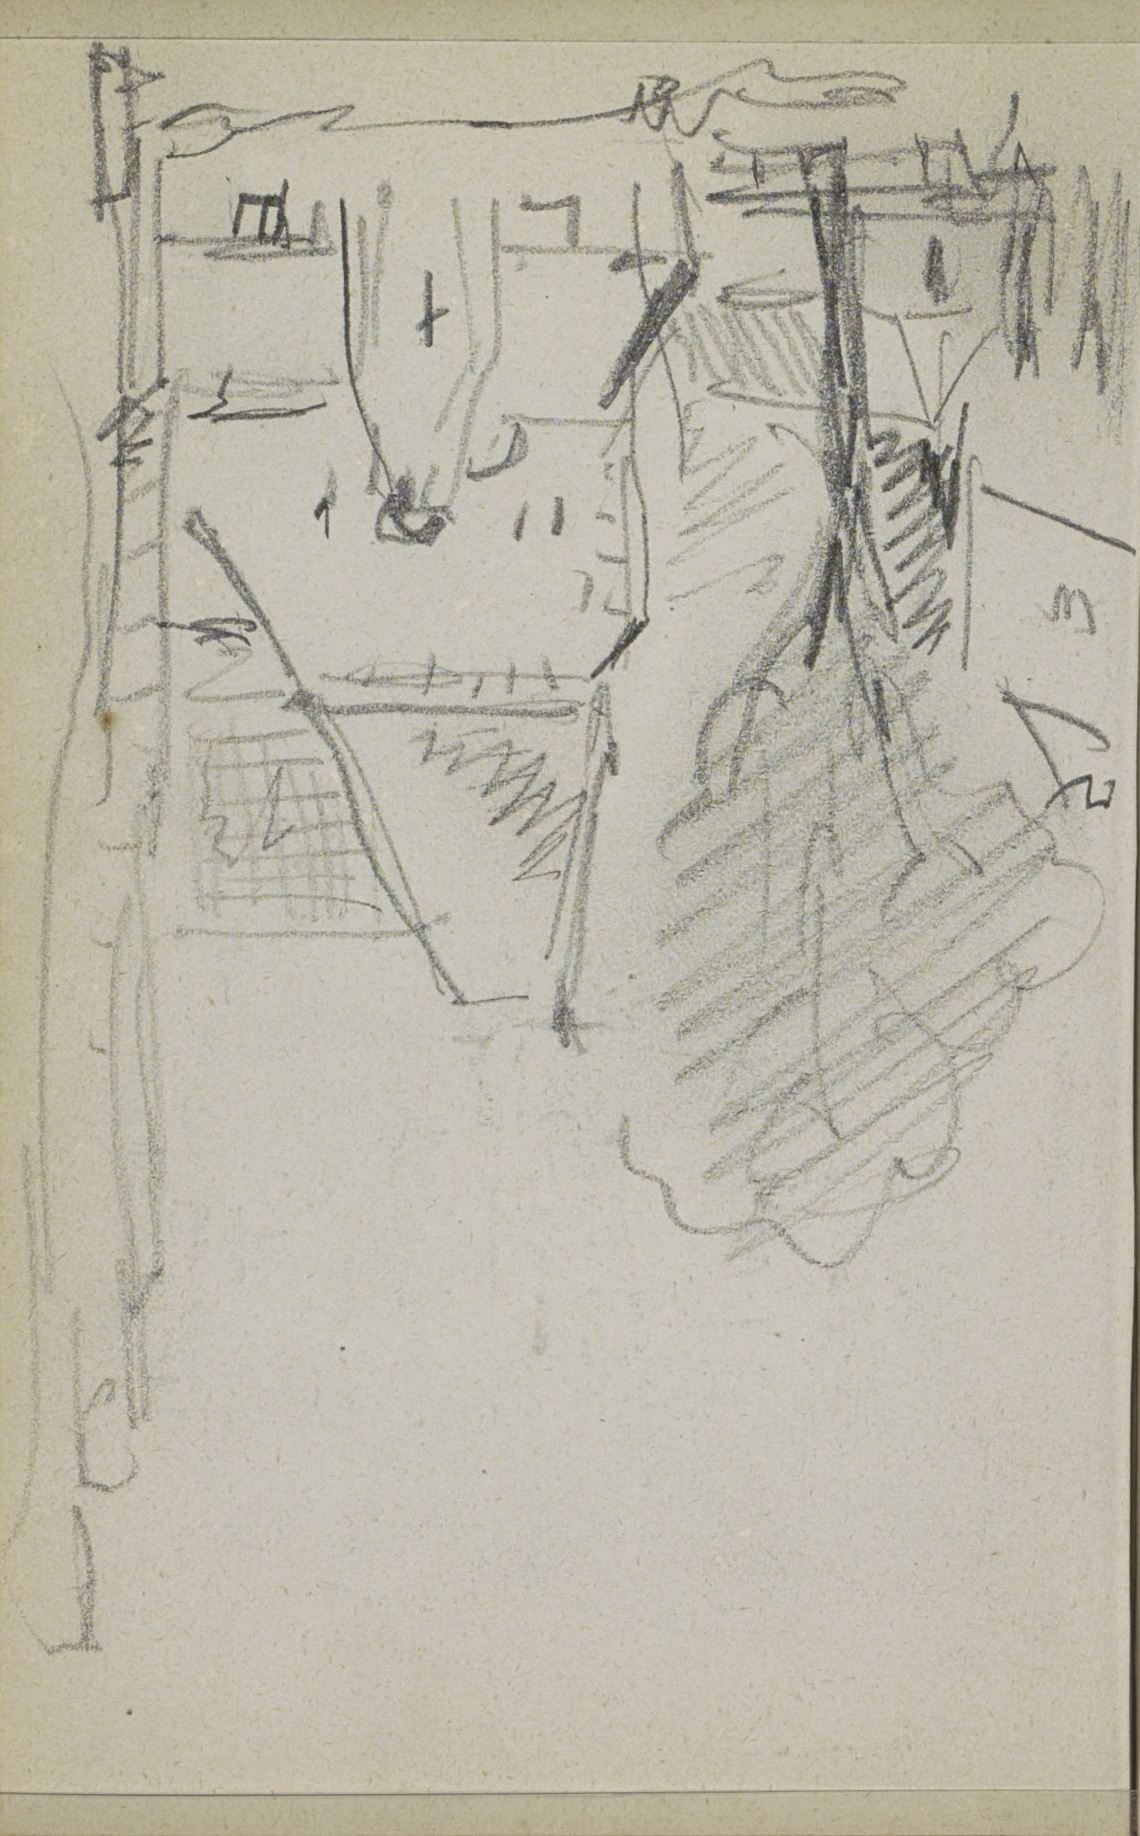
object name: sketchbook leaf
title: Gezicht op gebouwen rond een boom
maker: adrianus eversen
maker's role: draughtsman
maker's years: 1818-1897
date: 1828-1897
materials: paper, pencil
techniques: stumping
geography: netherlands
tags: urban housing, city-view, and landscape with man-made constructions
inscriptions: kleurnotitie, handgeschreven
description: Gezicht op gebouwen rond een boom. Blad 35 verso uit een schetsboek met 58 bladen.